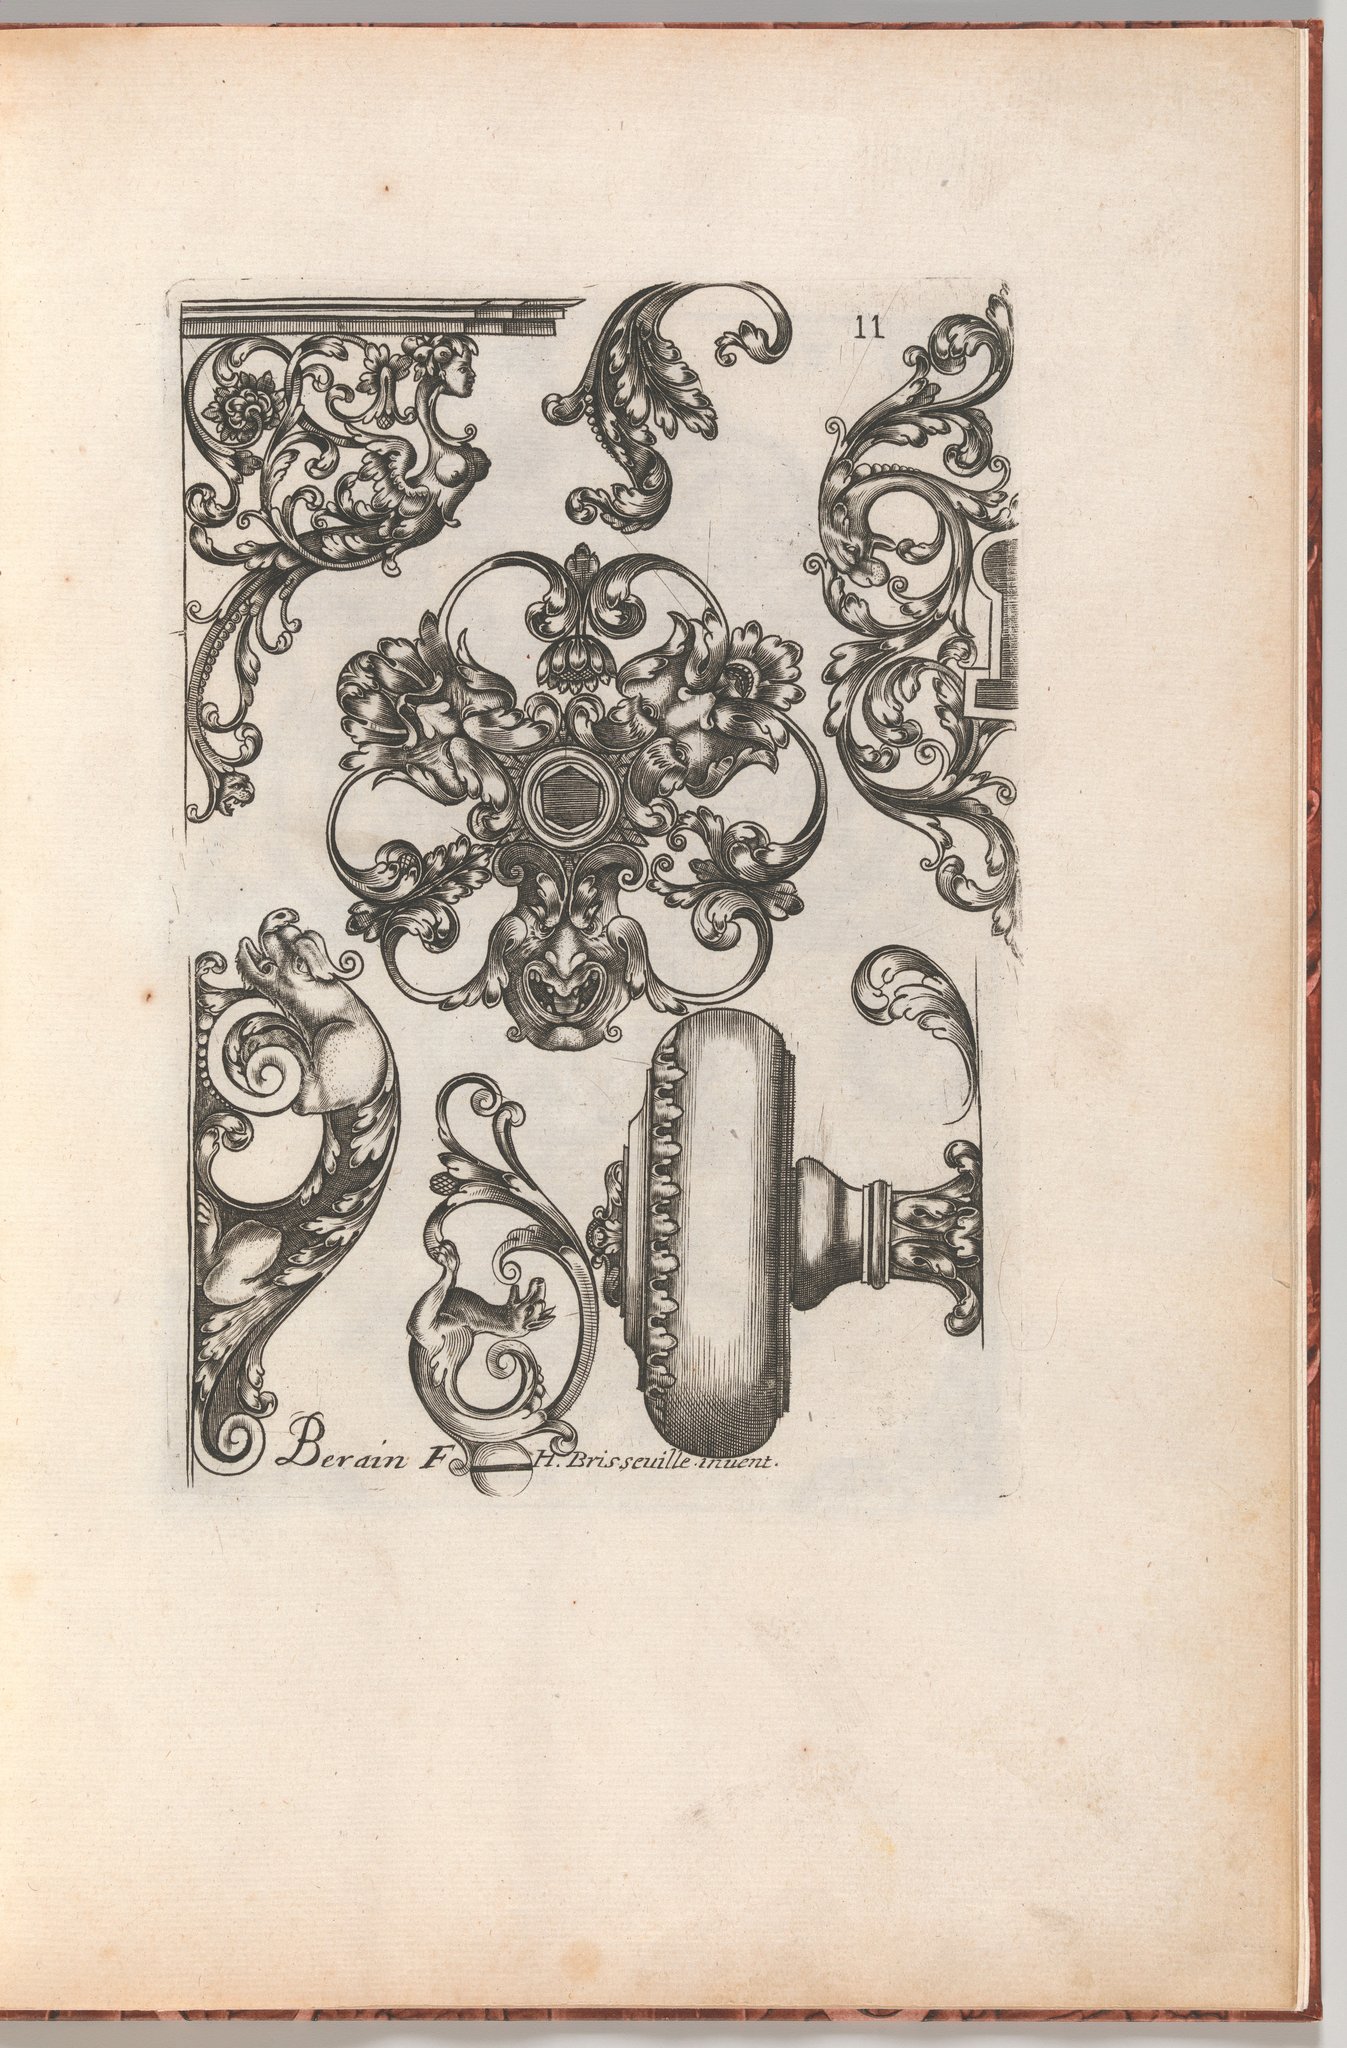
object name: album print ornament architecture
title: Diverses Pieces de Serruriers, page 12 (recto)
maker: jean berain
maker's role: artist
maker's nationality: french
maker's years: 1640-1711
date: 1663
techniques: engraving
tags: animals,grotesques,ornament,acanthus